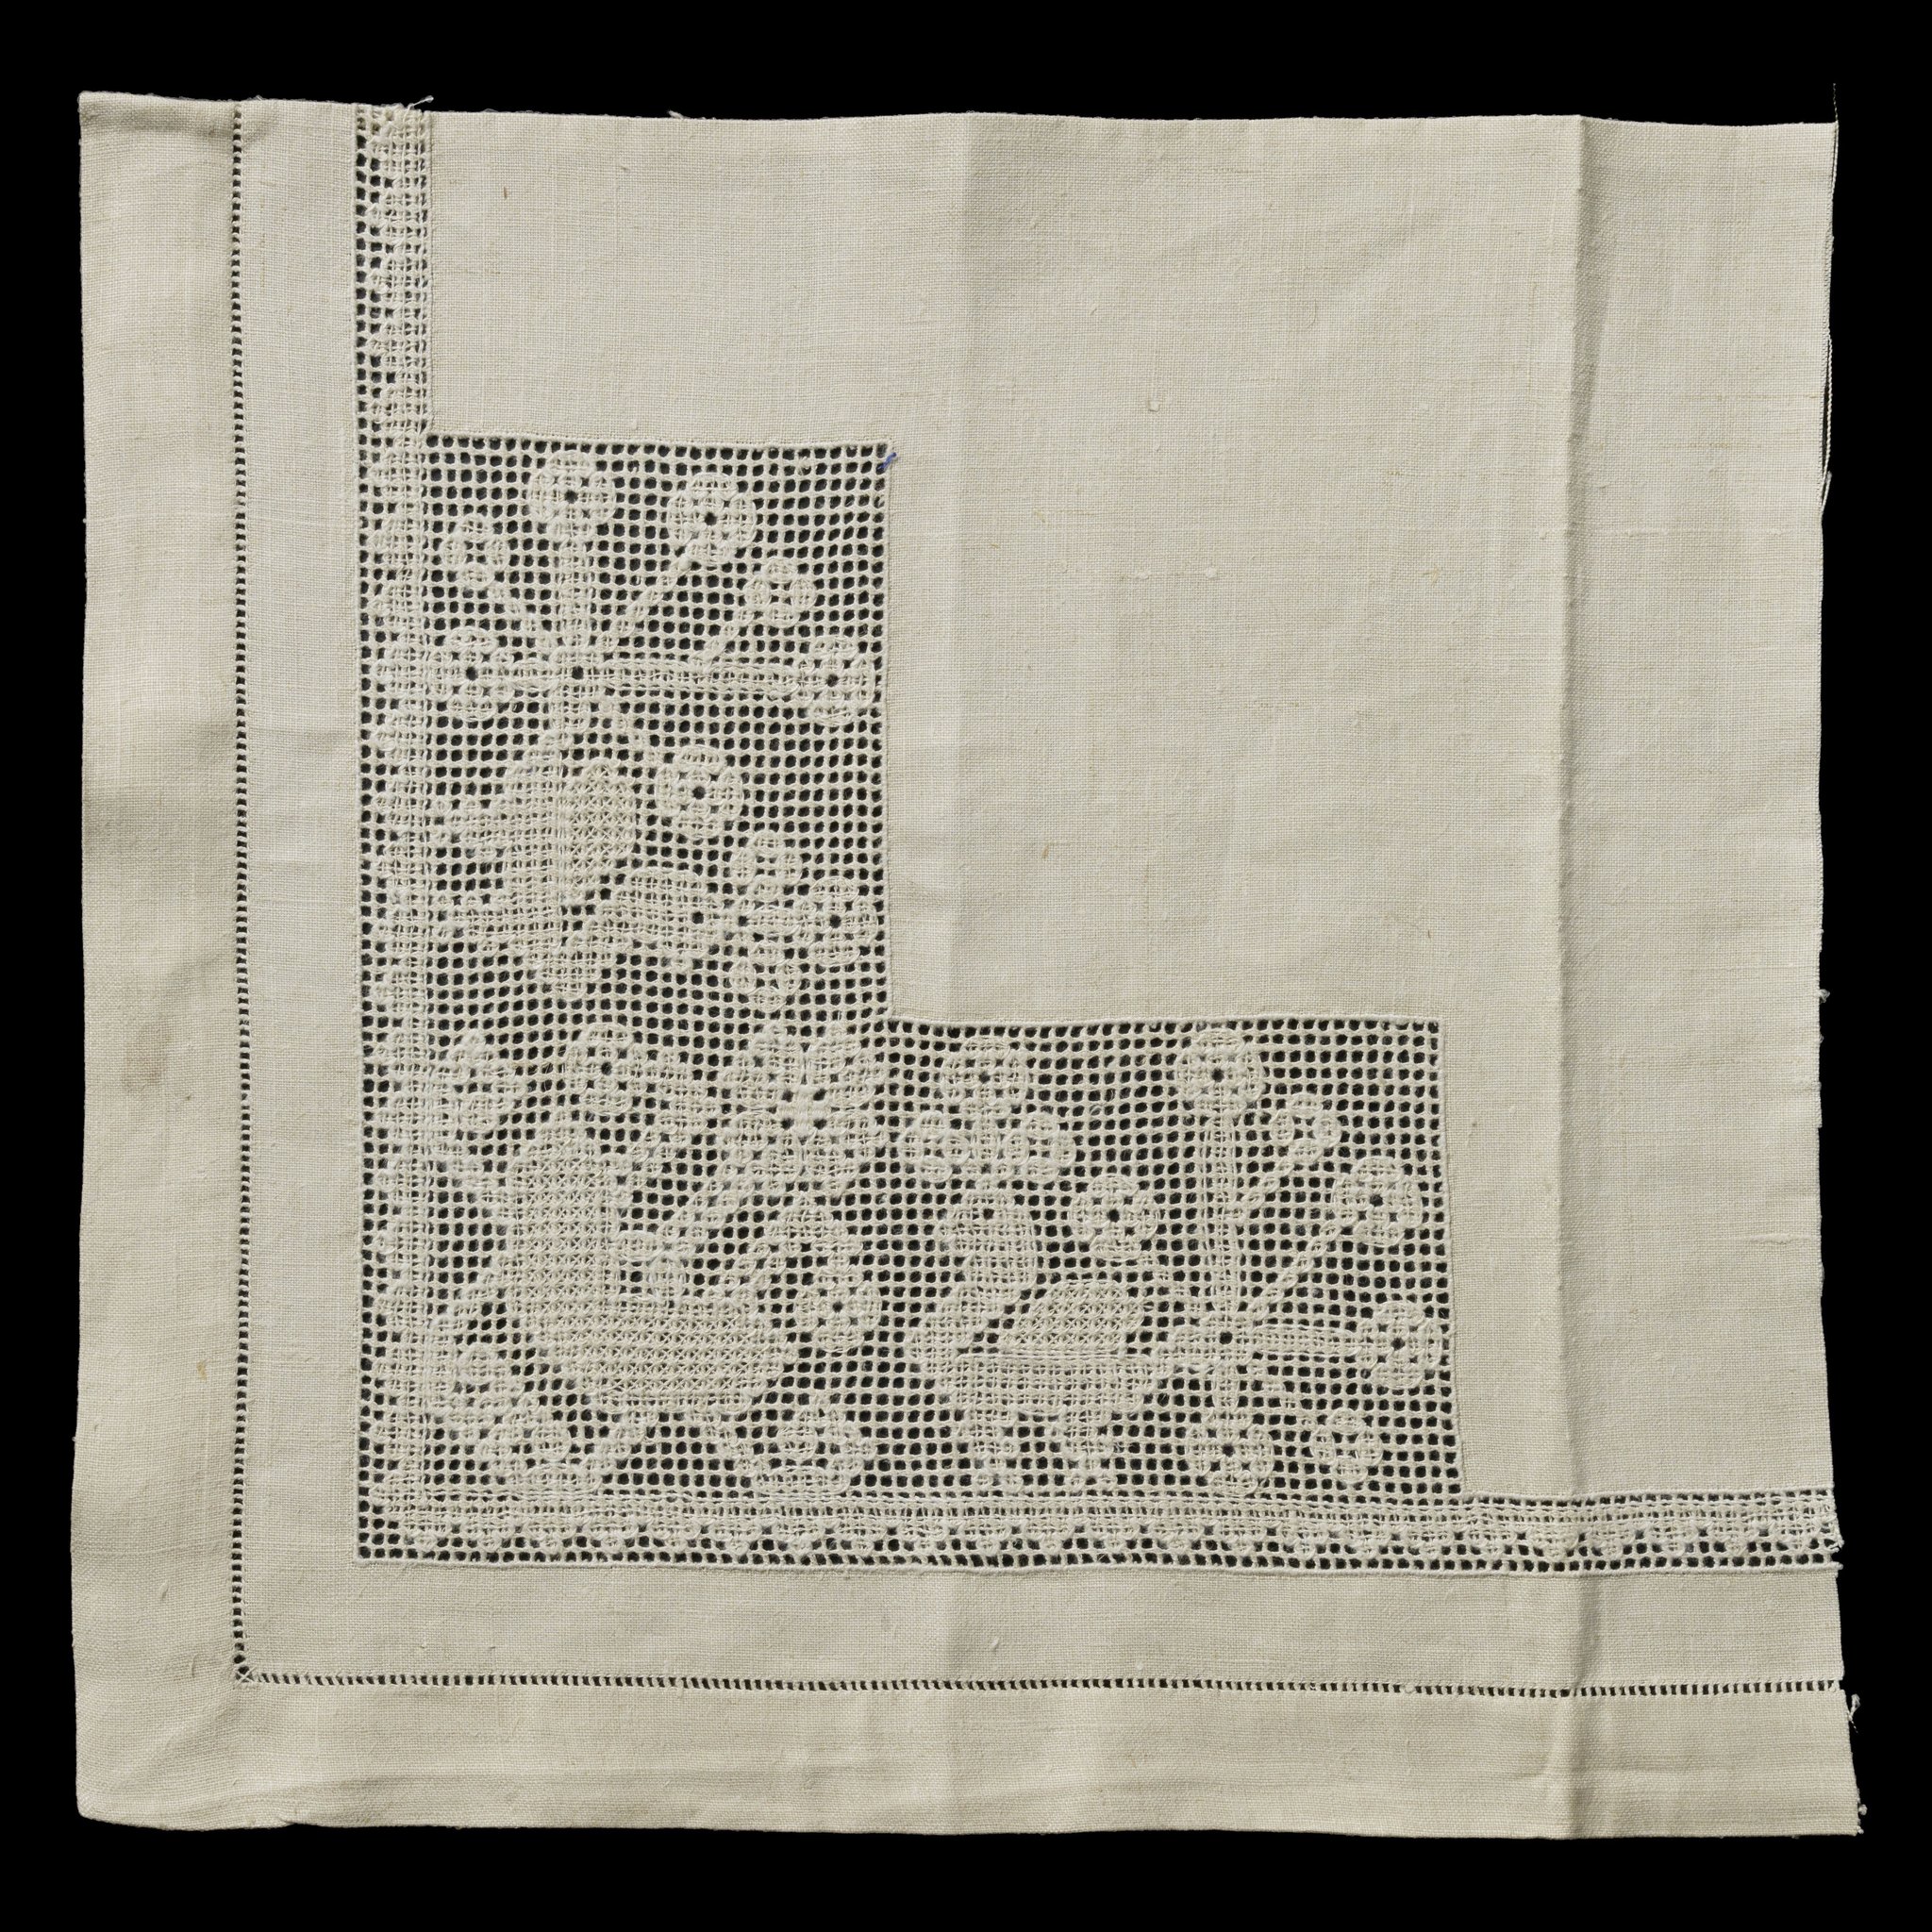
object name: lap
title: Lap van kantborduurwerk met pauwen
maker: Anonymous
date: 1925-1934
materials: linen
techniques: stopwork, lace embroidery, work with drawn threads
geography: russia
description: Lap van naturelkleurig kantborduurwerk, werk met samengetrokken draden en doorstopwerk. In de hoek van een linnen lap is door werk met samengetrokken draden een L-vorm van traliegrond gemaakt waarop doorstopwerk is aangebracht. In de hoek van de L staat een vaas of bloempot met een rechtopstaande rozetbloem en twee kleinere hangde rozetbloempjes. Dit motief is gevat tussen twee naar de hoek gewende pauwen met kuifjes en pronkstaarten. De lap is aan twee kanten om het patroon heen afgewerkt met een zoom. De andere twee kanten zijn niet afgewerkt. De lap lijkt uit een groter vierkant of een grotere rechthoek geknipt te zijn.